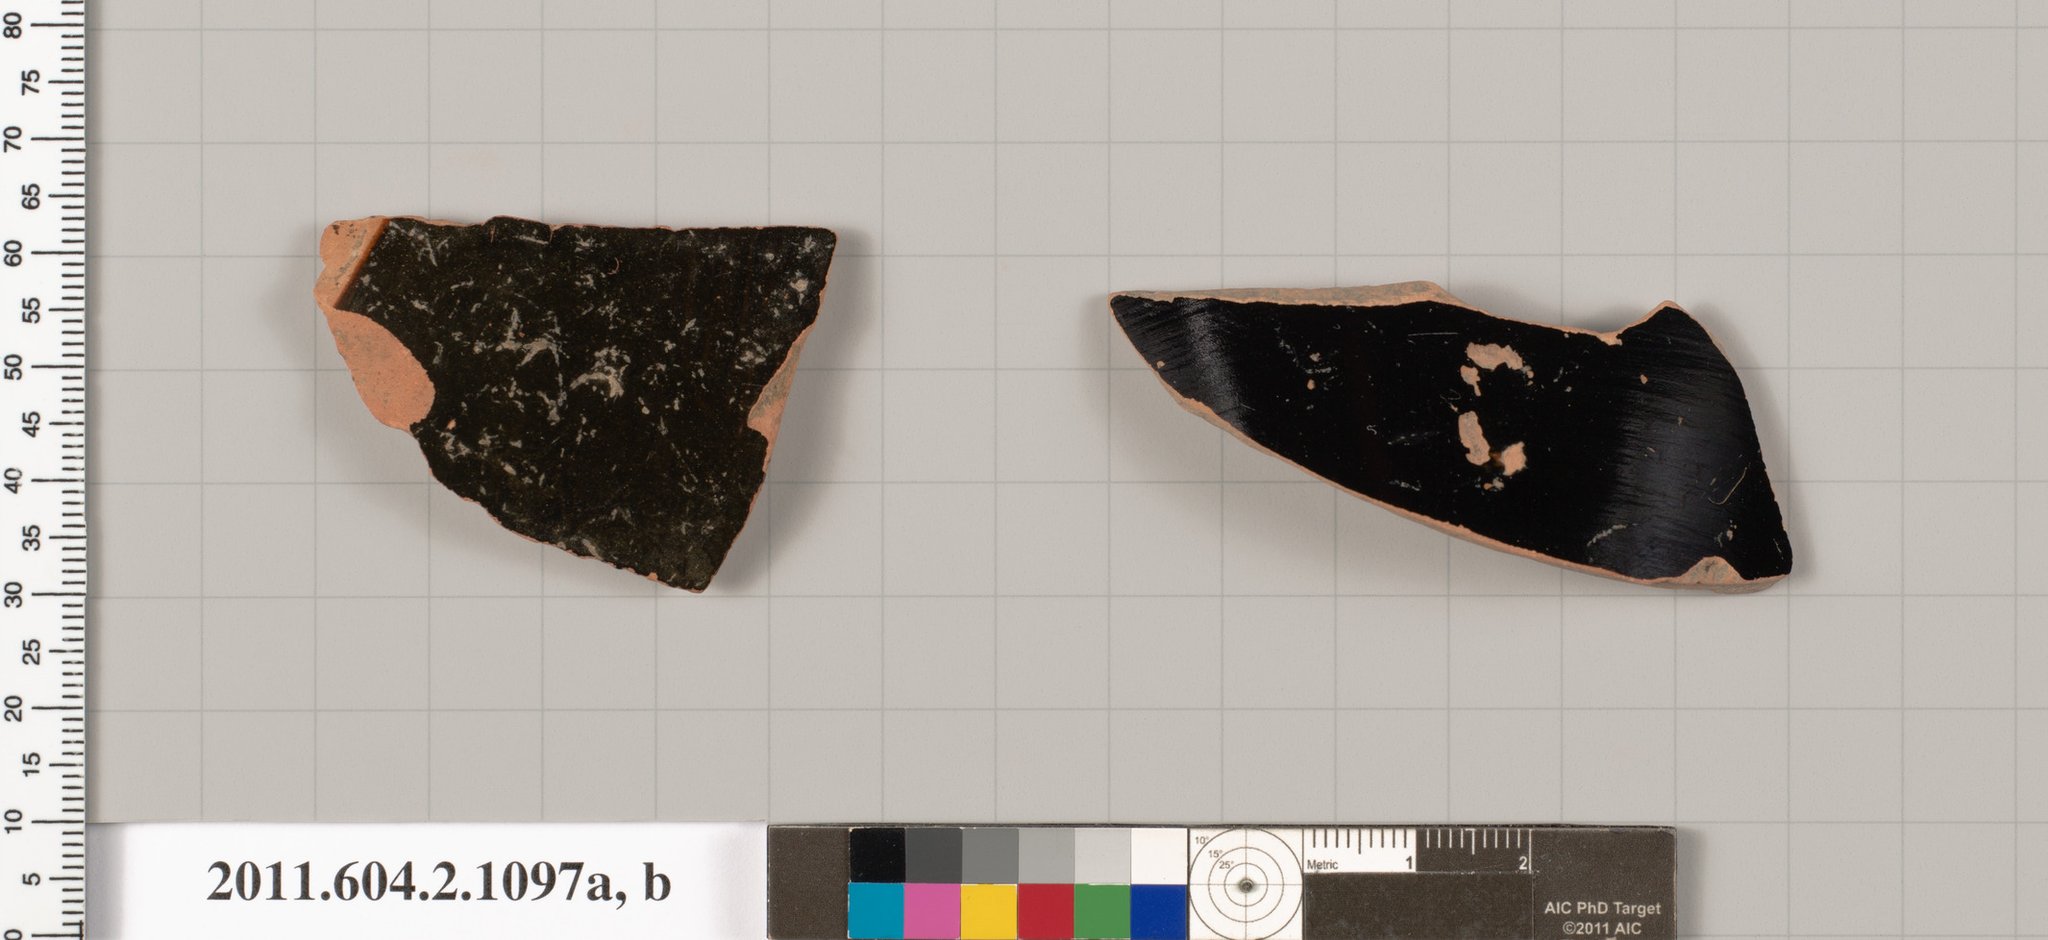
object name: lekythos fragment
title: Terracotta fragments of lekythoi (oil flasks)?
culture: greek, attic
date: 500-451 BCE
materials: terracotta